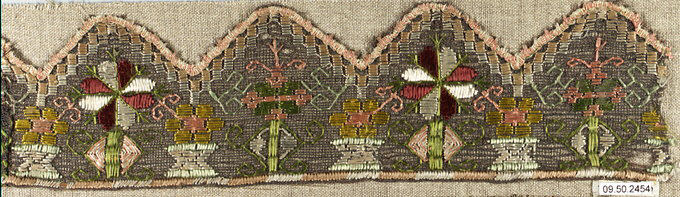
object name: edging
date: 1601-1700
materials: silk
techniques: embroidery